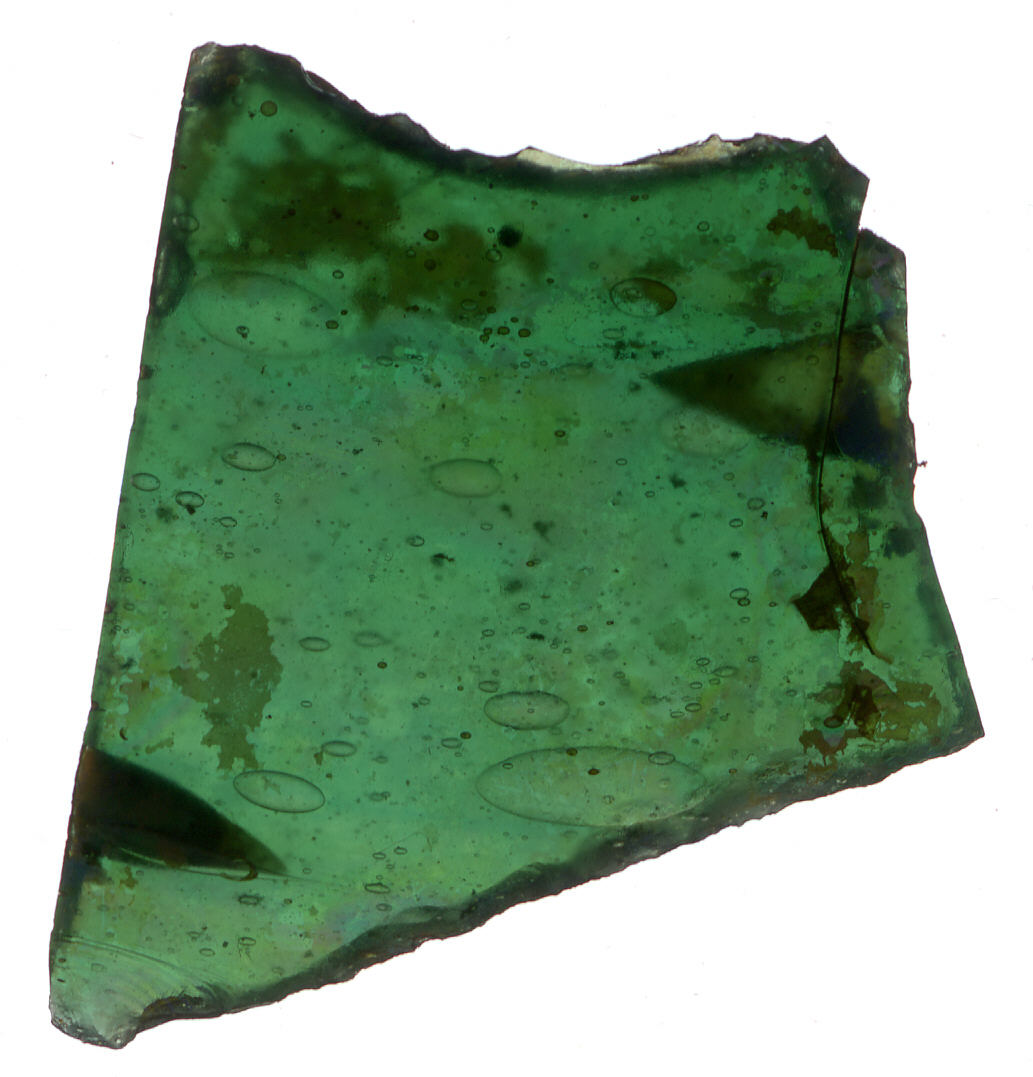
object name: fragment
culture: crusader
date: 1201-1300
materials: glass